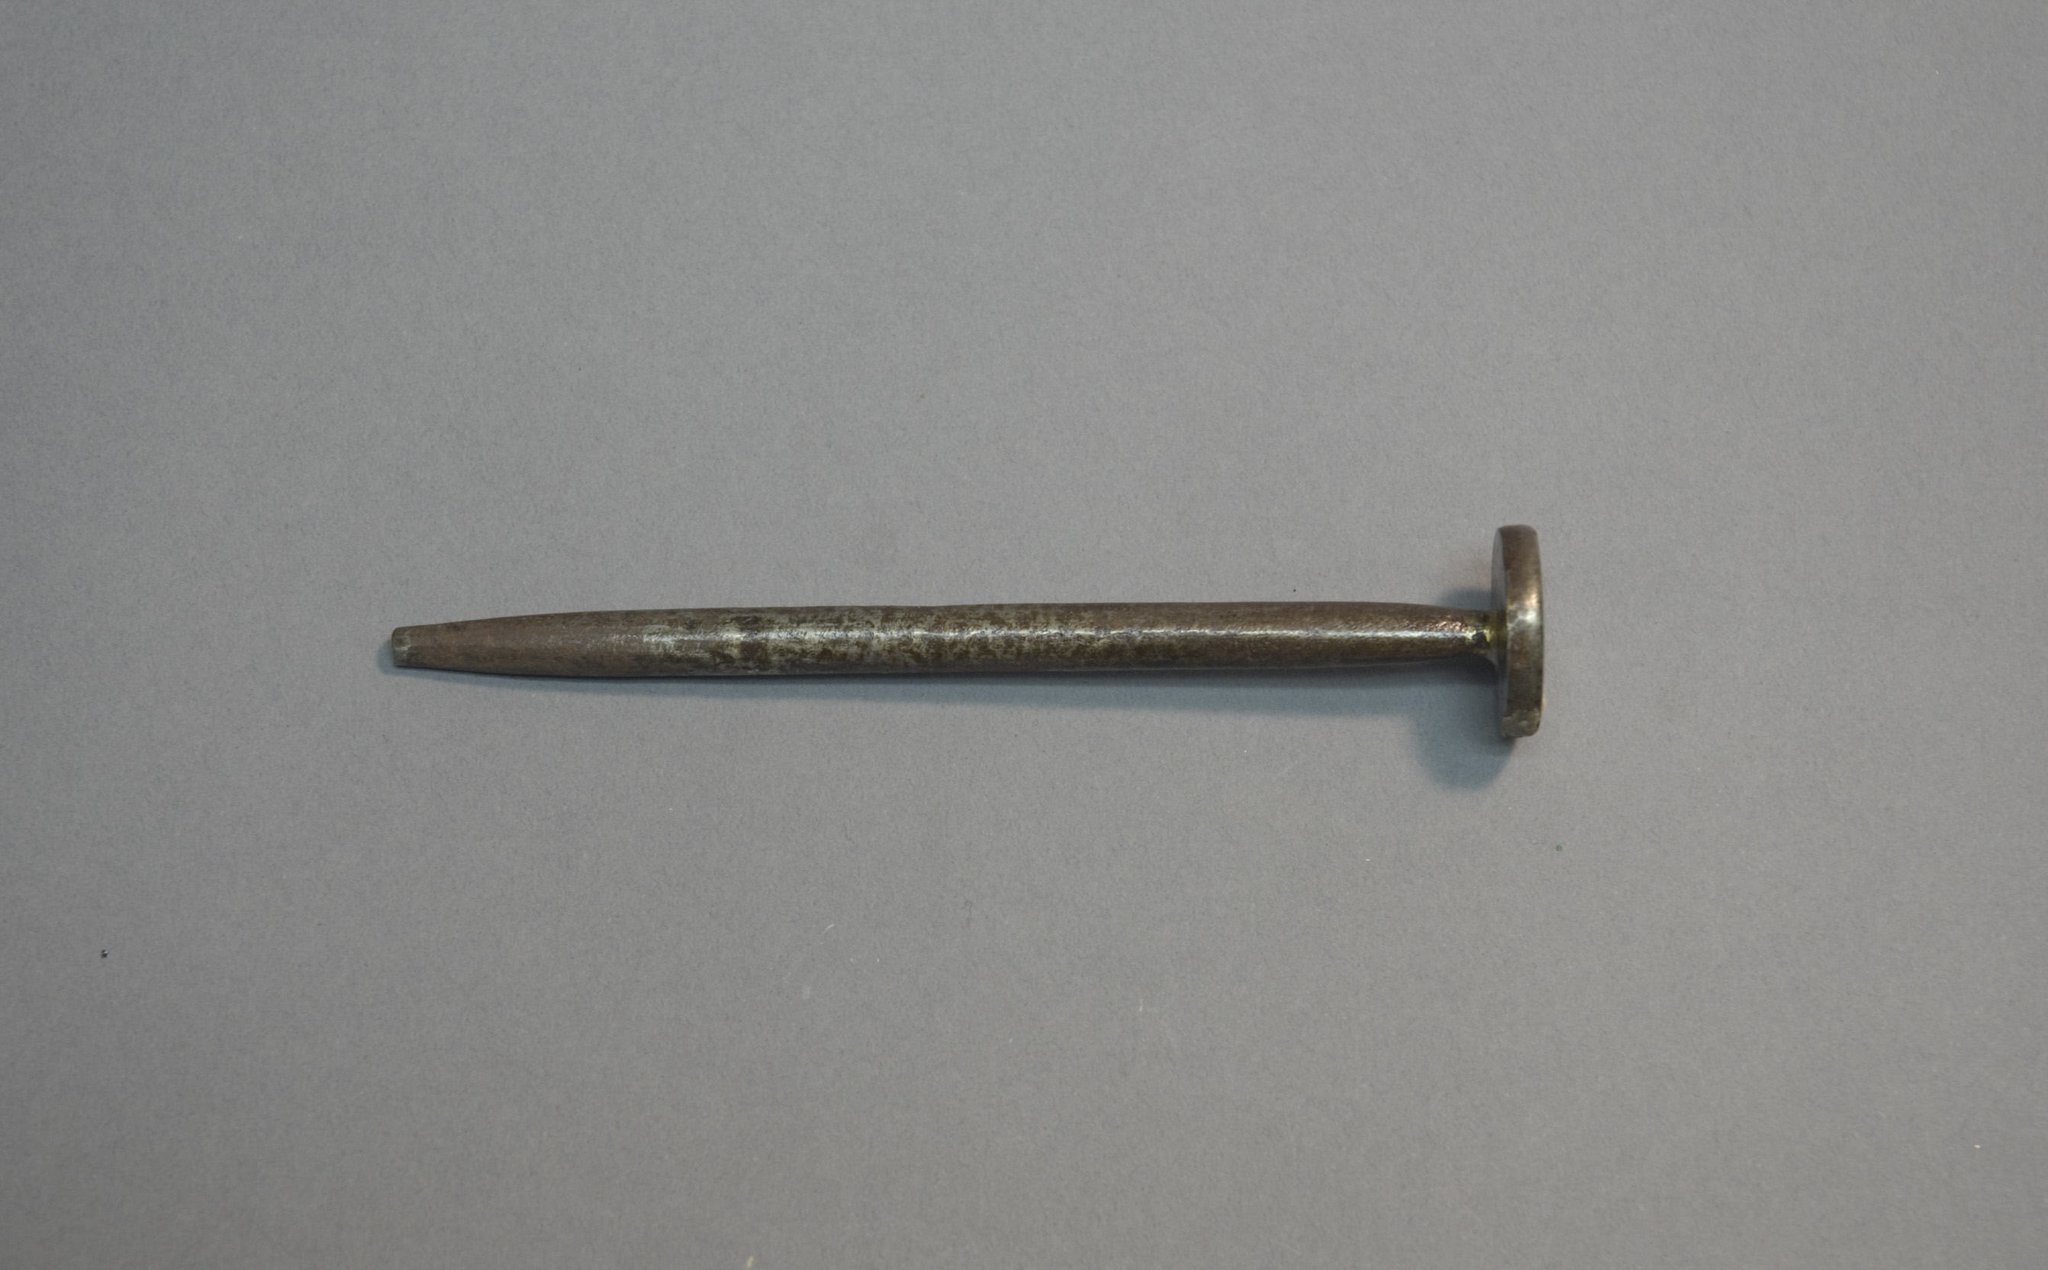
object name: jade carving tool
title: Engraving wheel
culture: chinese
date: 1901-2000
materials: steel